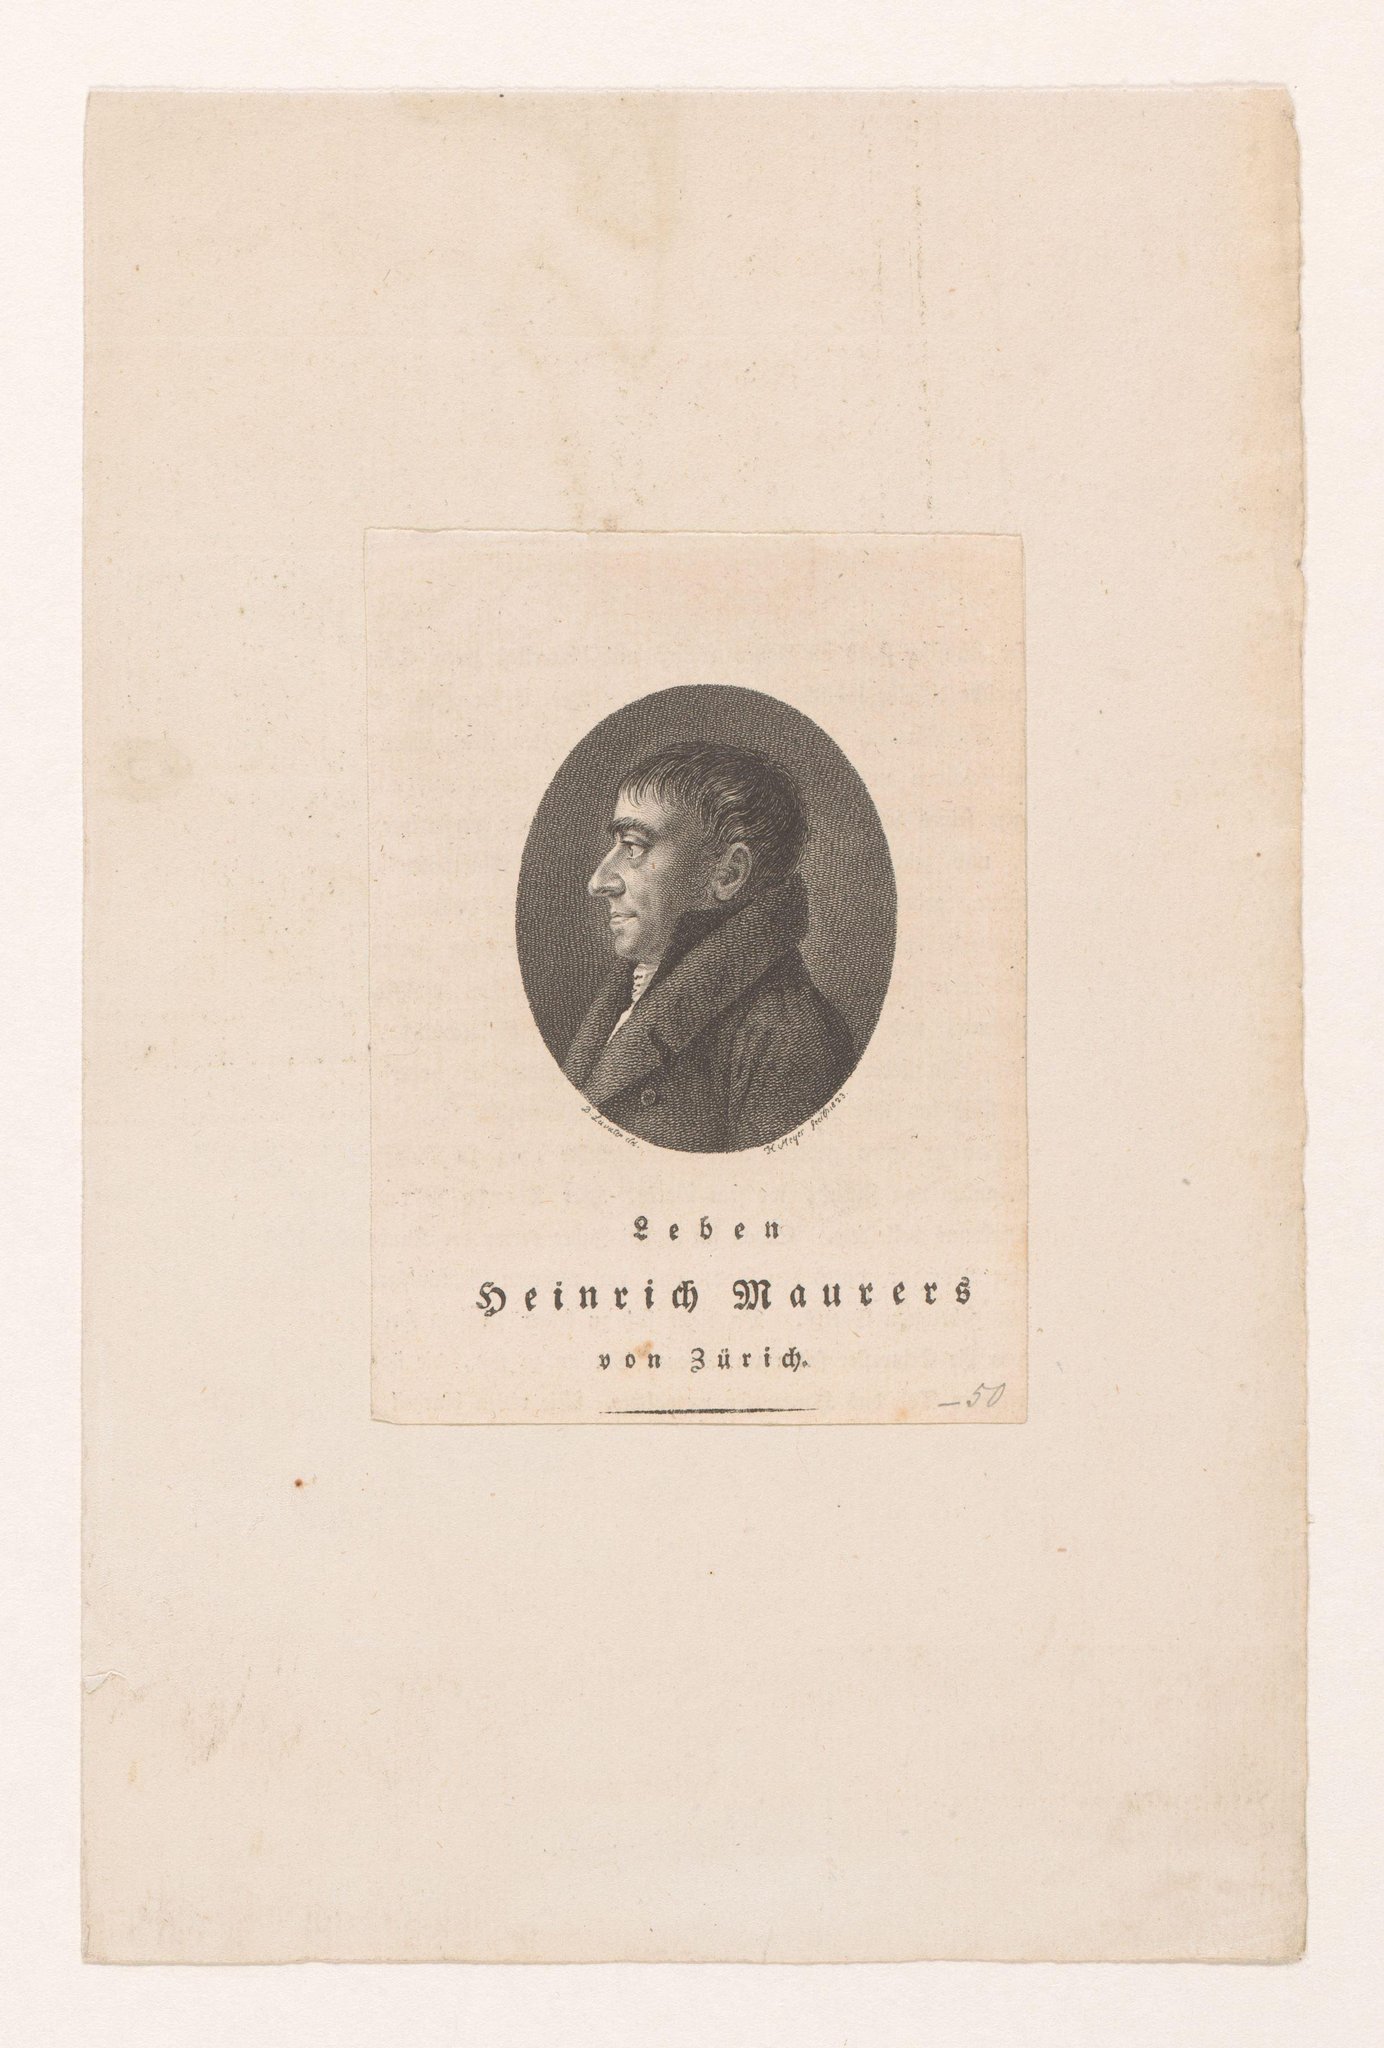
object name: print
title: Portret van Heinrich Maurer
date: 1823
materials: paper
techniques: etching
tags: painter, print maker, historical persons, portrait, self-portrait of graphic artist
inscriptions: collector's mark: Lugt 2228